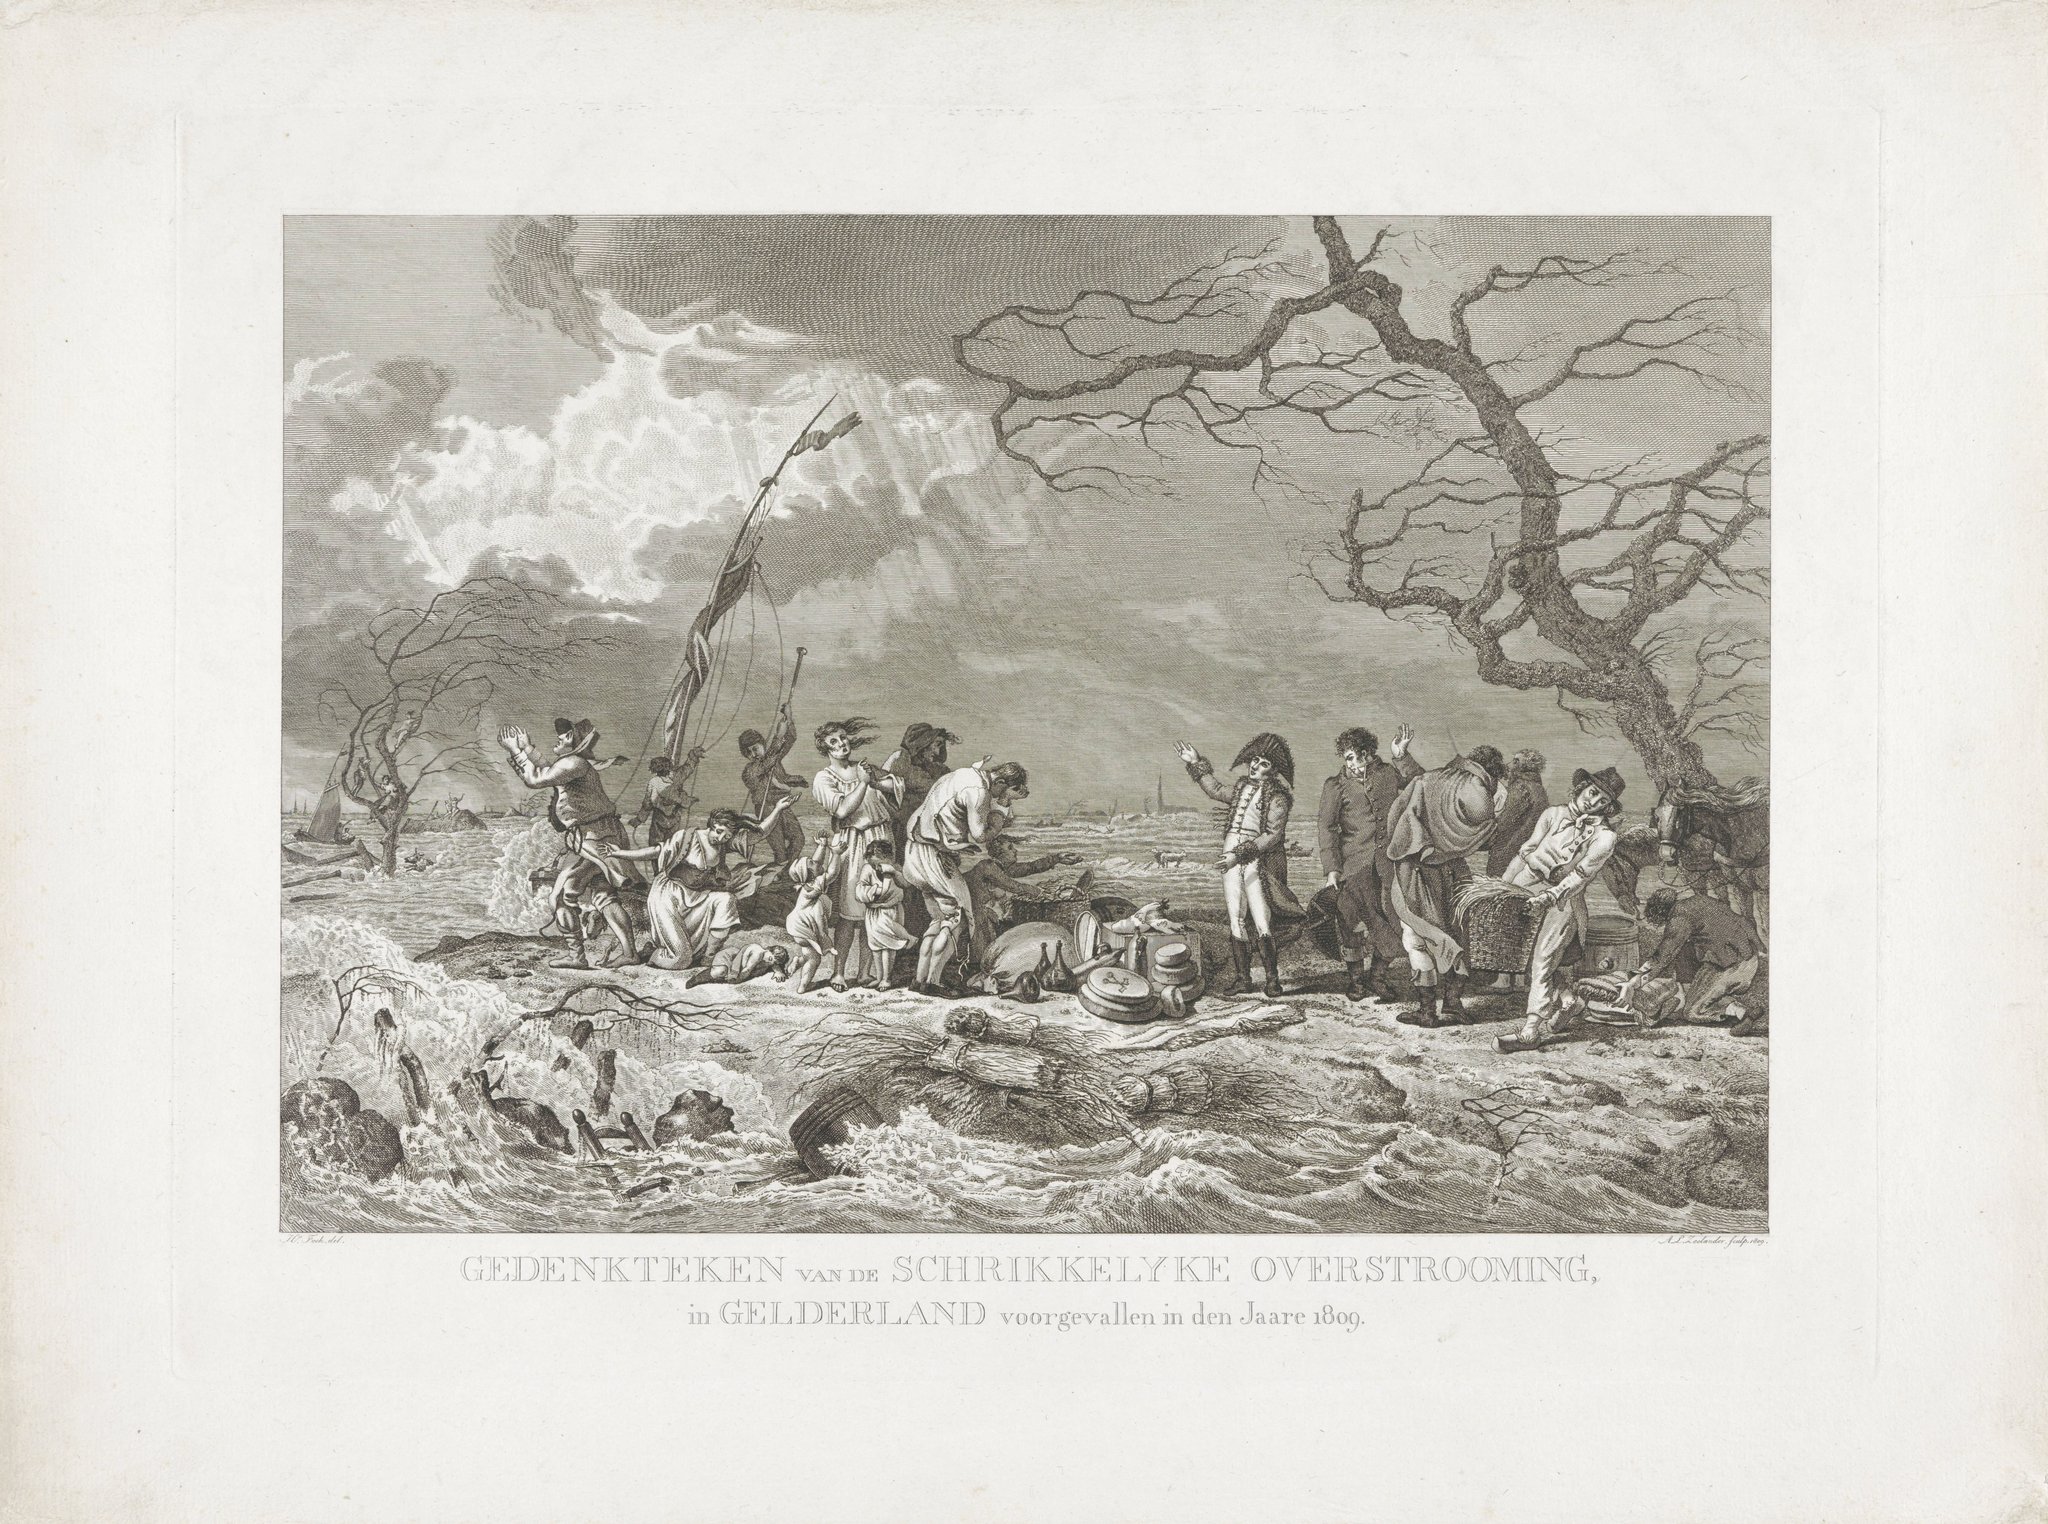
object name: print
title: Gedenkteken van de Schrikkelyke Overstrooming, in Gelderland voorgevallen in de Jaare 1809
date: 1809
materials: paper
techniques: engraving, etching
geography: netherlands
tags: louis napoleon (king of holland), dike-break, gelderland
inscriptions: collector's mark: Lugt 2228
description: Koning Lodewijk Napoleon deelt eten en drinken en dekens uit aan slachtoffers van de watersnood in Gelderland, 1809. Op een stuk land omgeven door het water staat een groep wanhopige mensen, rechts worden de noodvoorzieningen aangevoerd.